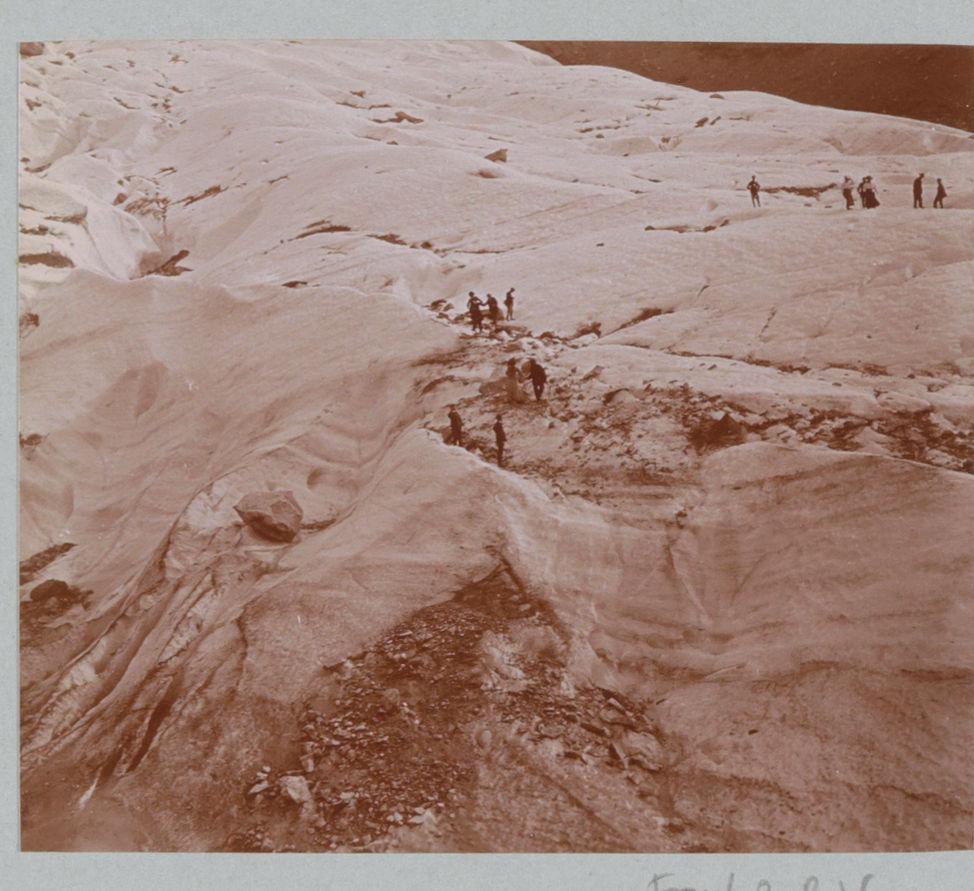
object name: photograph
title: Wandelaars op besneeuwde bergflanken in de Alpen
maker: Anonymous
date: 1905-1910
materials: paper, photographic support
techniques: gelatin silver print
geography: alps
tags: walking, hiking (recreation), mountains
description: Onderdeel van Fotoalbum van een Franse amateurfotograaf met bezienswaardigheden in Frankrijk, Zwitserland en Italië.